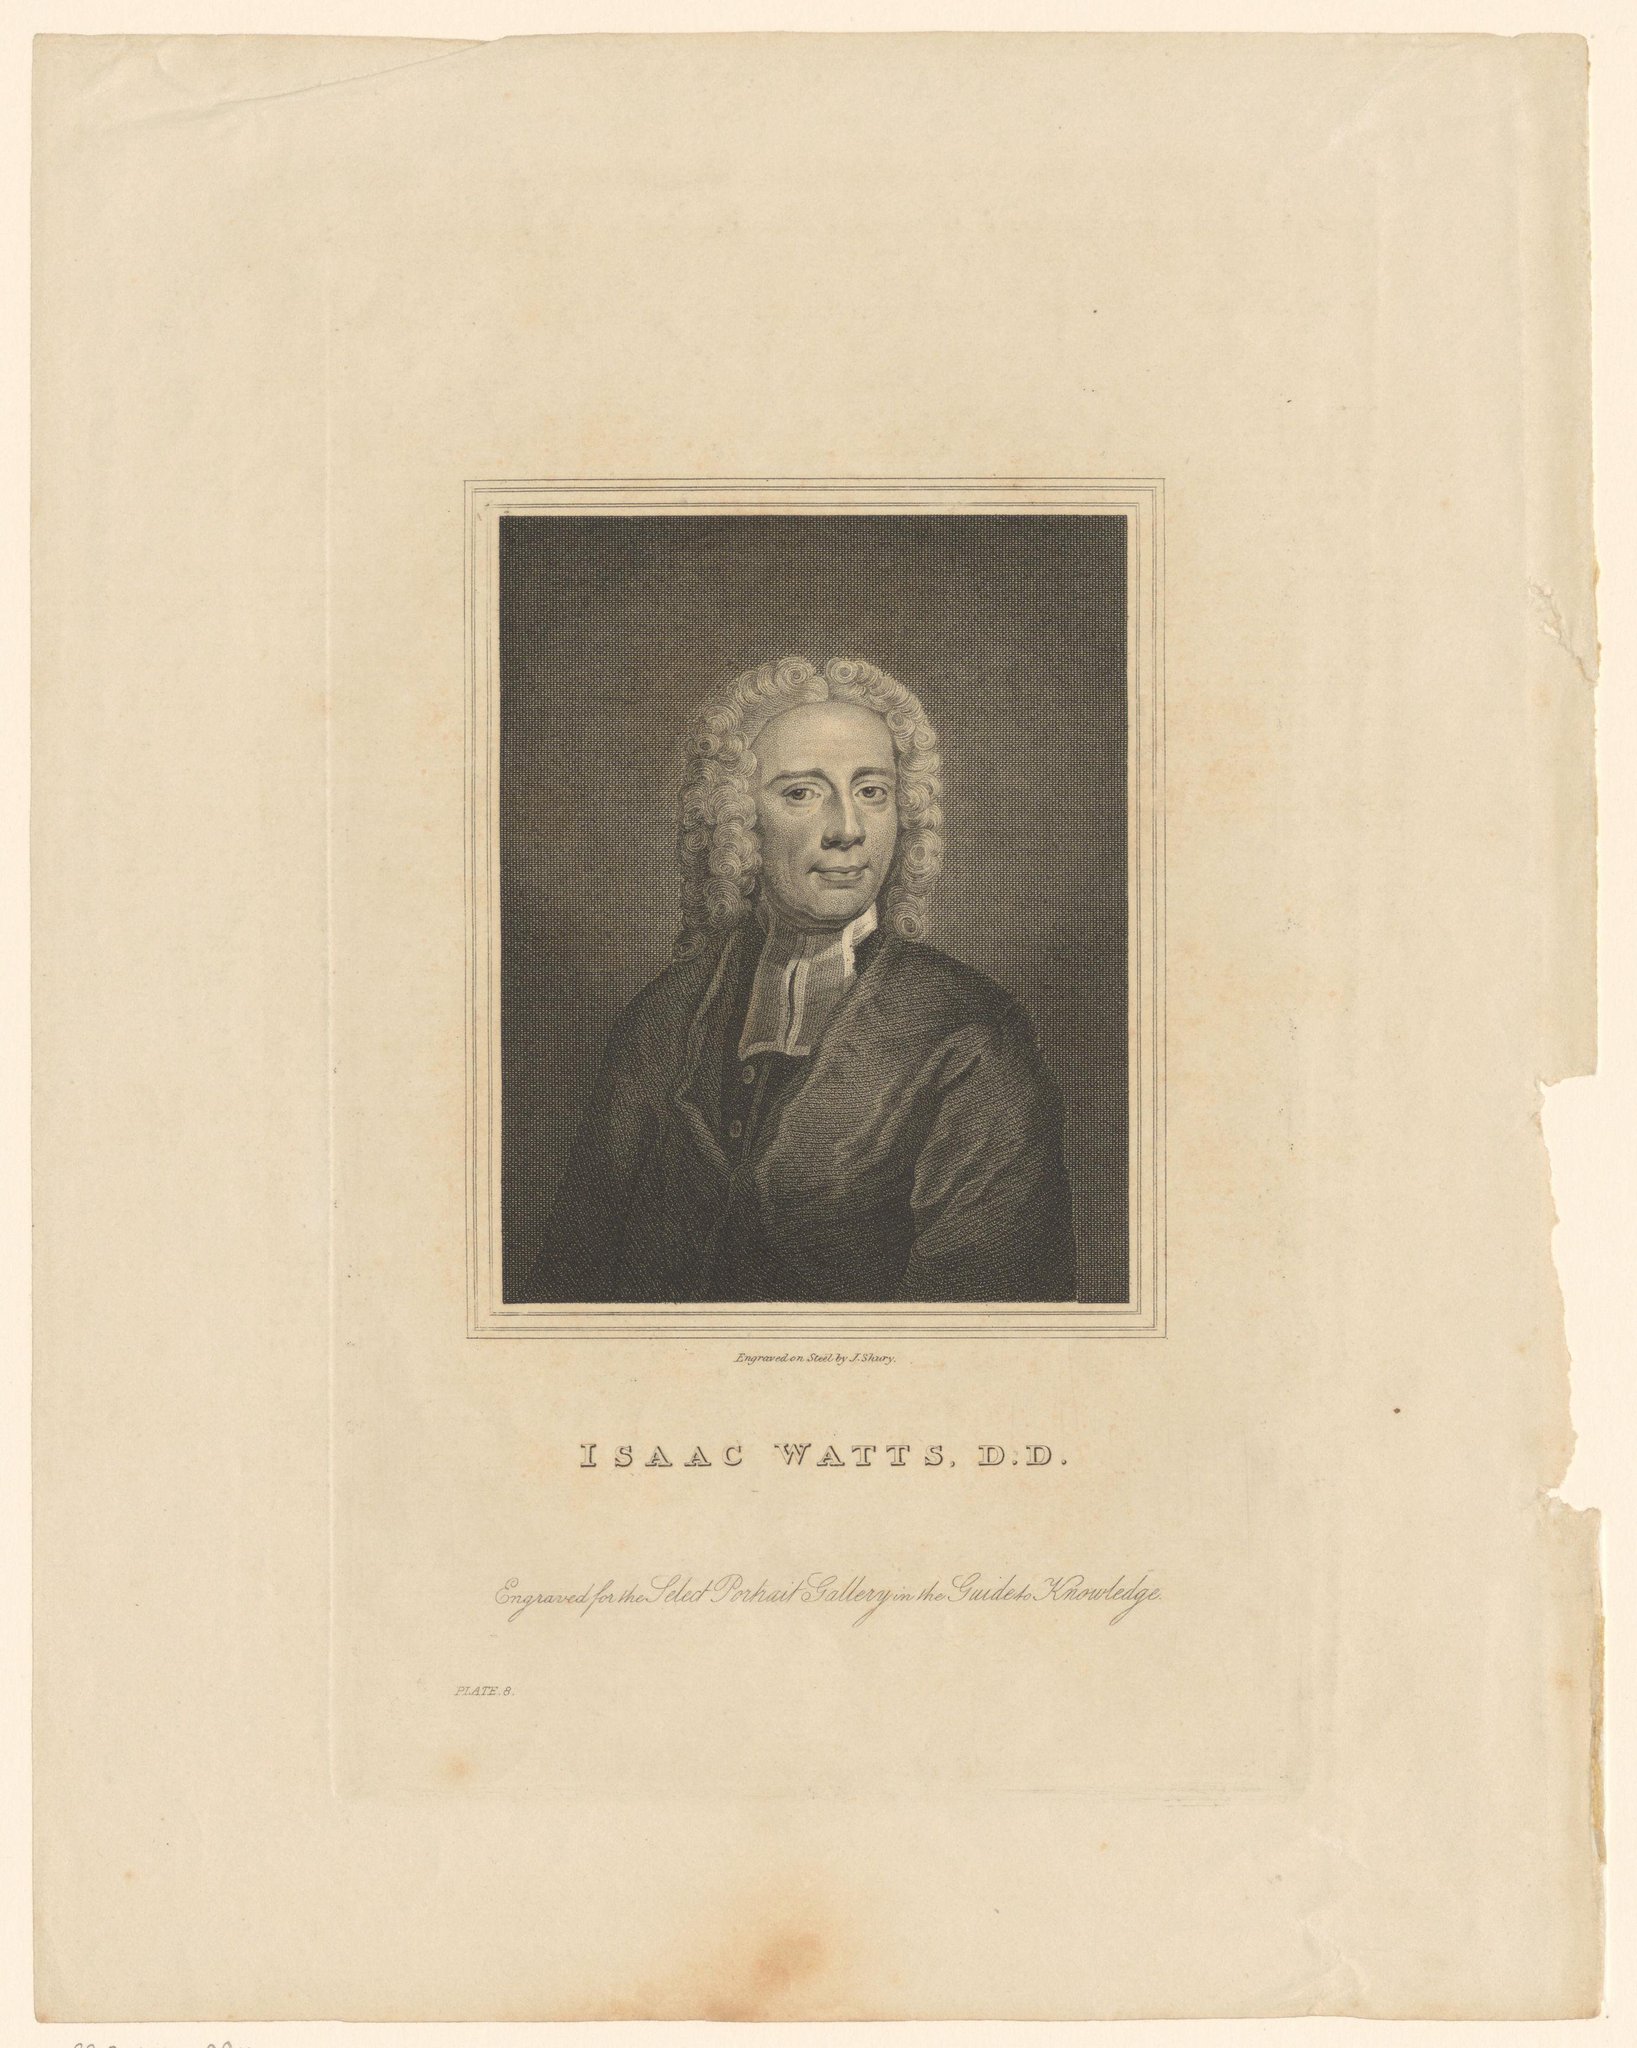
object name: book illustration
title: Portret van Isaac Watts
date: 1837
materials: paper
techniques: etching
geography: great britain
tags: theologian, historical persons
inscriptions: collector's mark: Lugt 2228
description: Prent uit: Gilbert, James. The Guide to Knowledge (...). Londen: Orlando Hodgson, 1837, dl. 1.